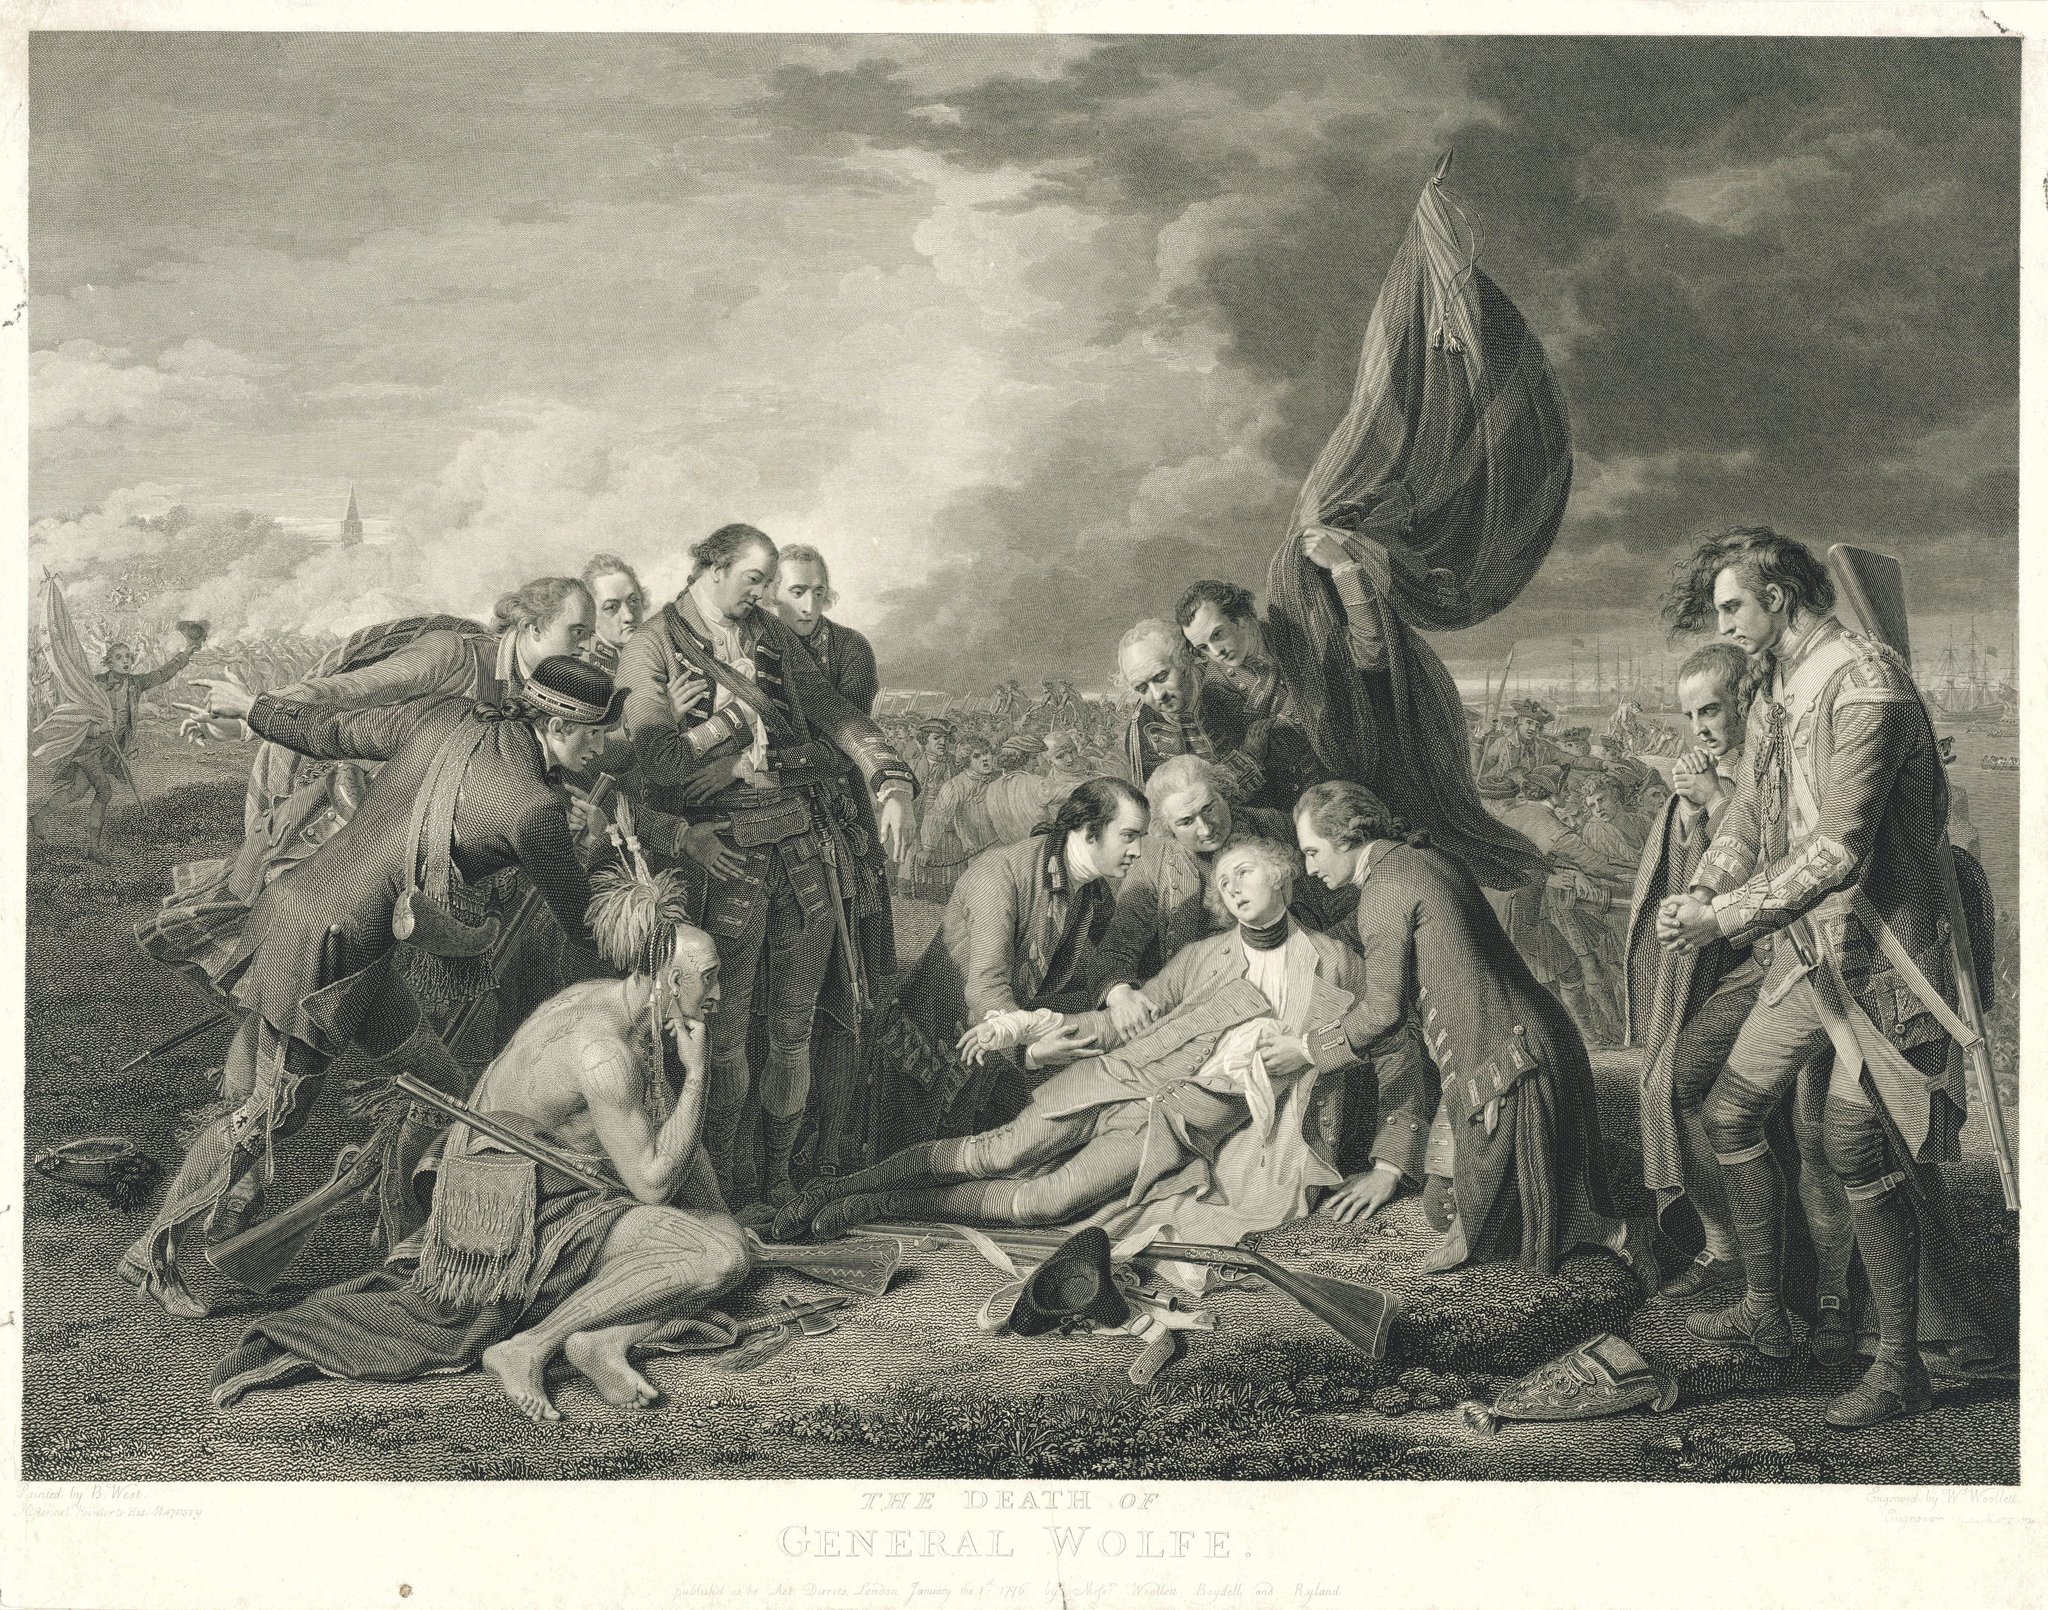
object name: print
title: Dood van James Wolfe tijdens de Slag om Quebec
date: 1701-1776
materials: paper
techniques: engraving, etching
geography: london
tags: québec, robert monckton, painter, indigenous peoples of north america, violent death by firearms, battle (+ land forces)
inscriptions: collector's mark: Lugt 12